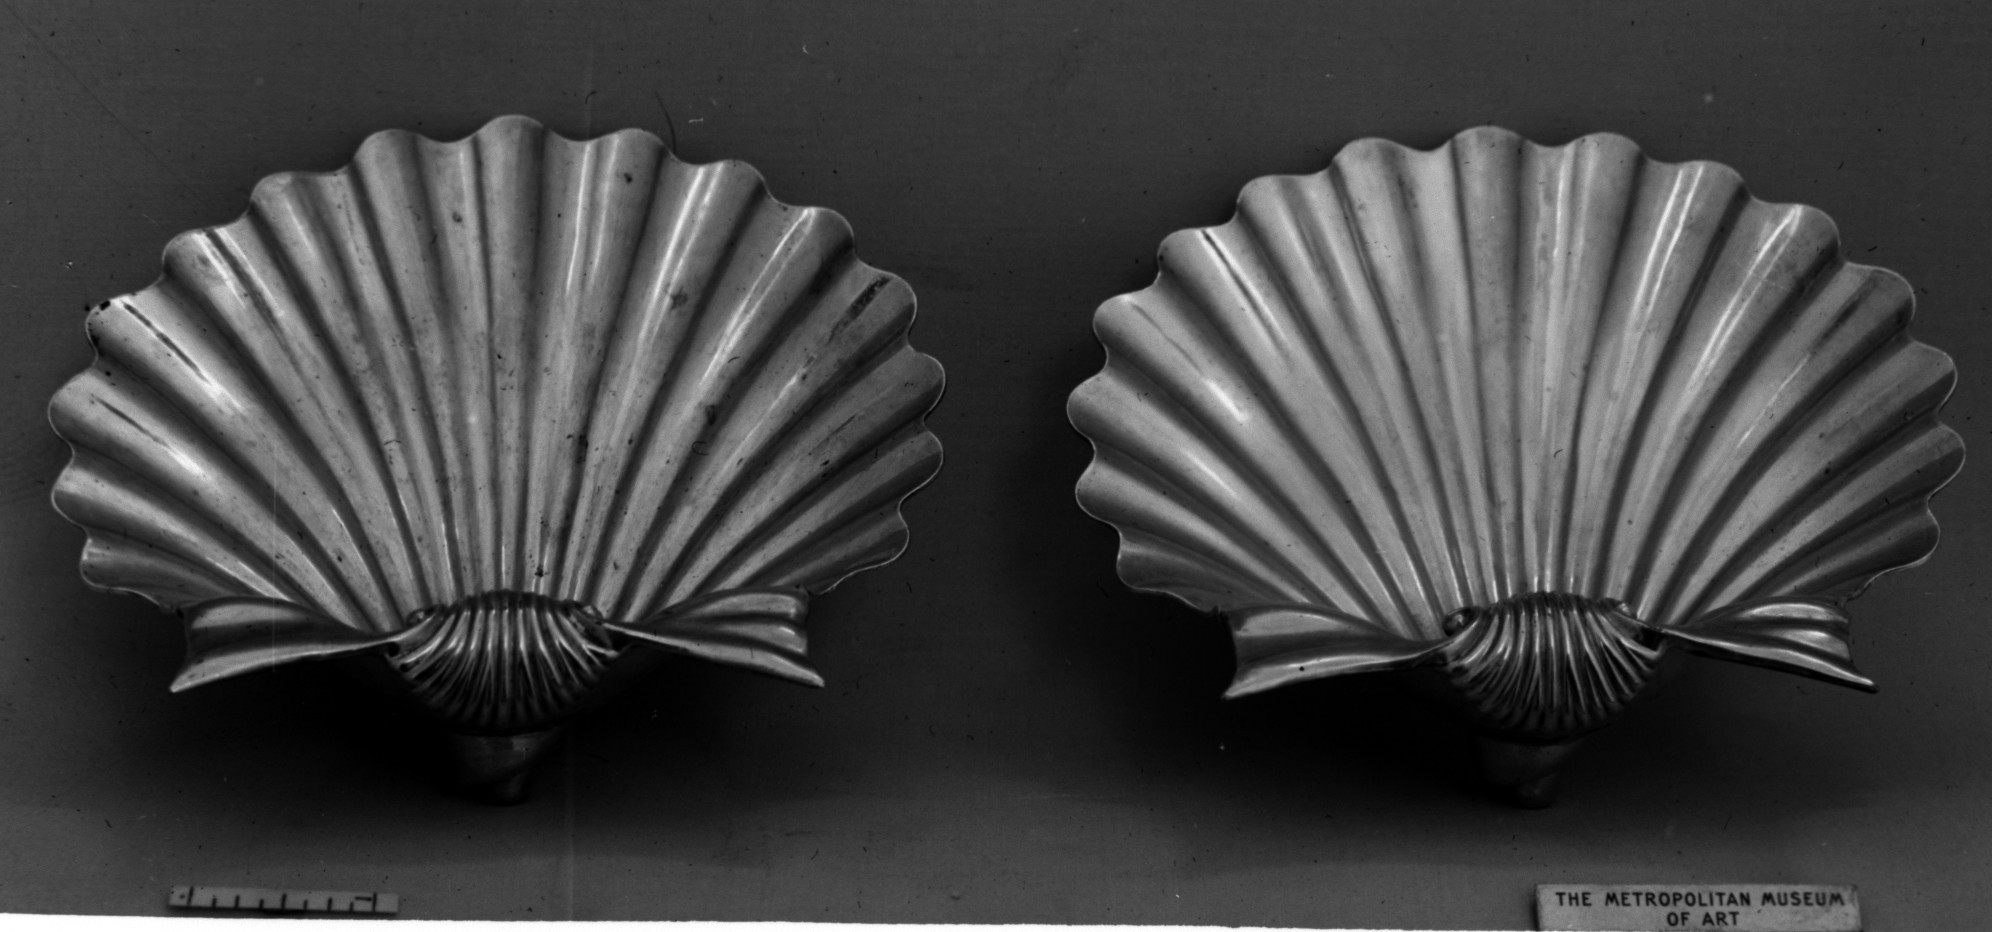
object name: dish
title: Pair of dishes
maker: t. and j. creswick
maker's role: maker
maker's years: 1811-1857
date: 1810-1830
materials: metal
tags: shells